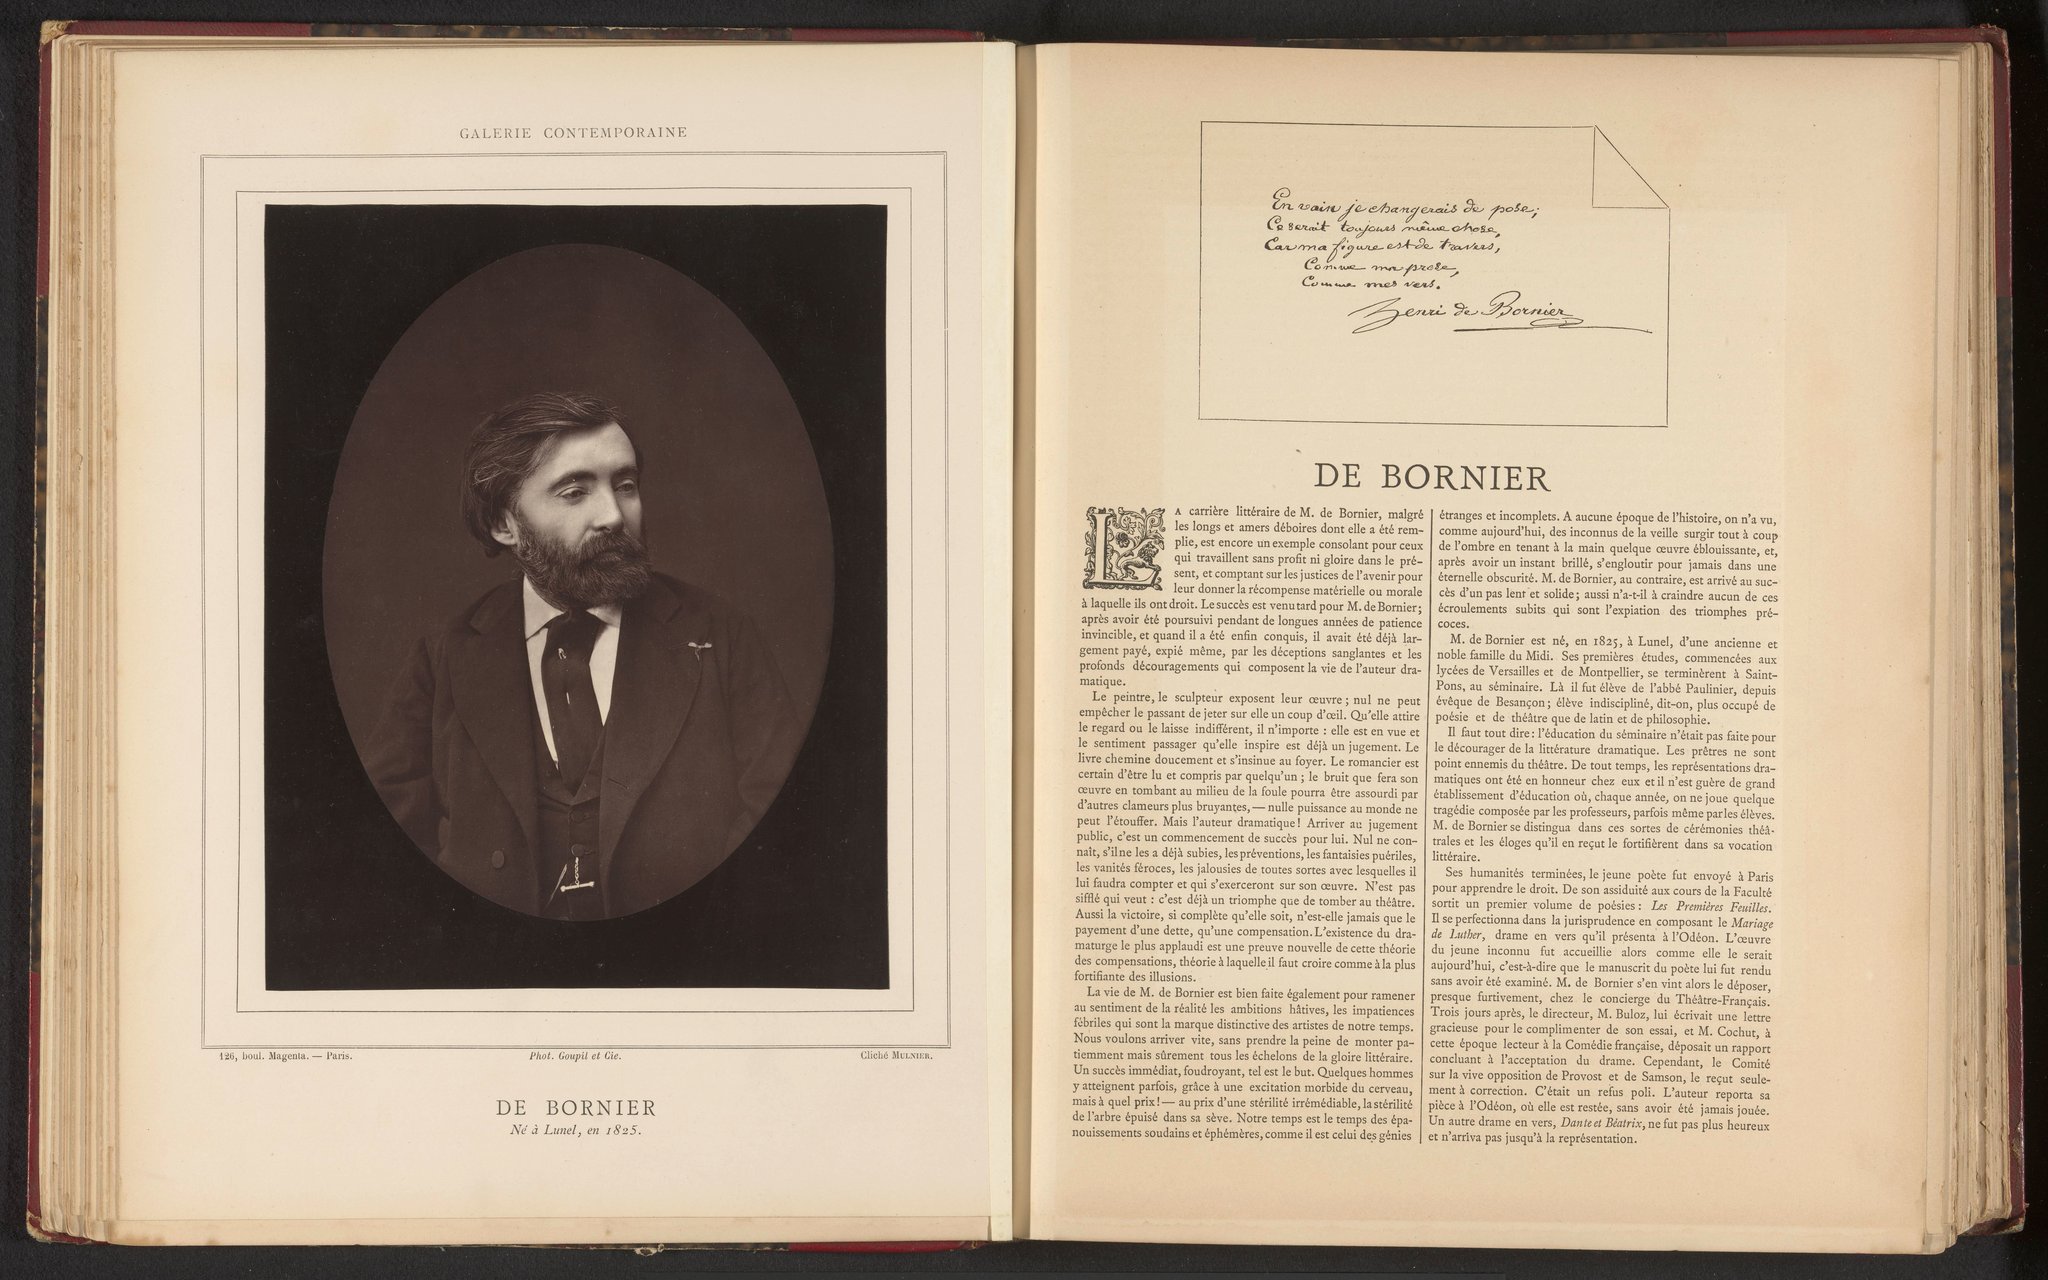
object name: page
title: De Bornier. Ne a Lunel, en 1825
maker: ferdinand mulnier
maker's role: painter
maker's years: 1817-1891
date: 1876-1879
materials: paper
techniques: woodburytype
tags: writer, poet, author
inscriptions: inscription: ‘126, boul. Magenta.-Paris.’